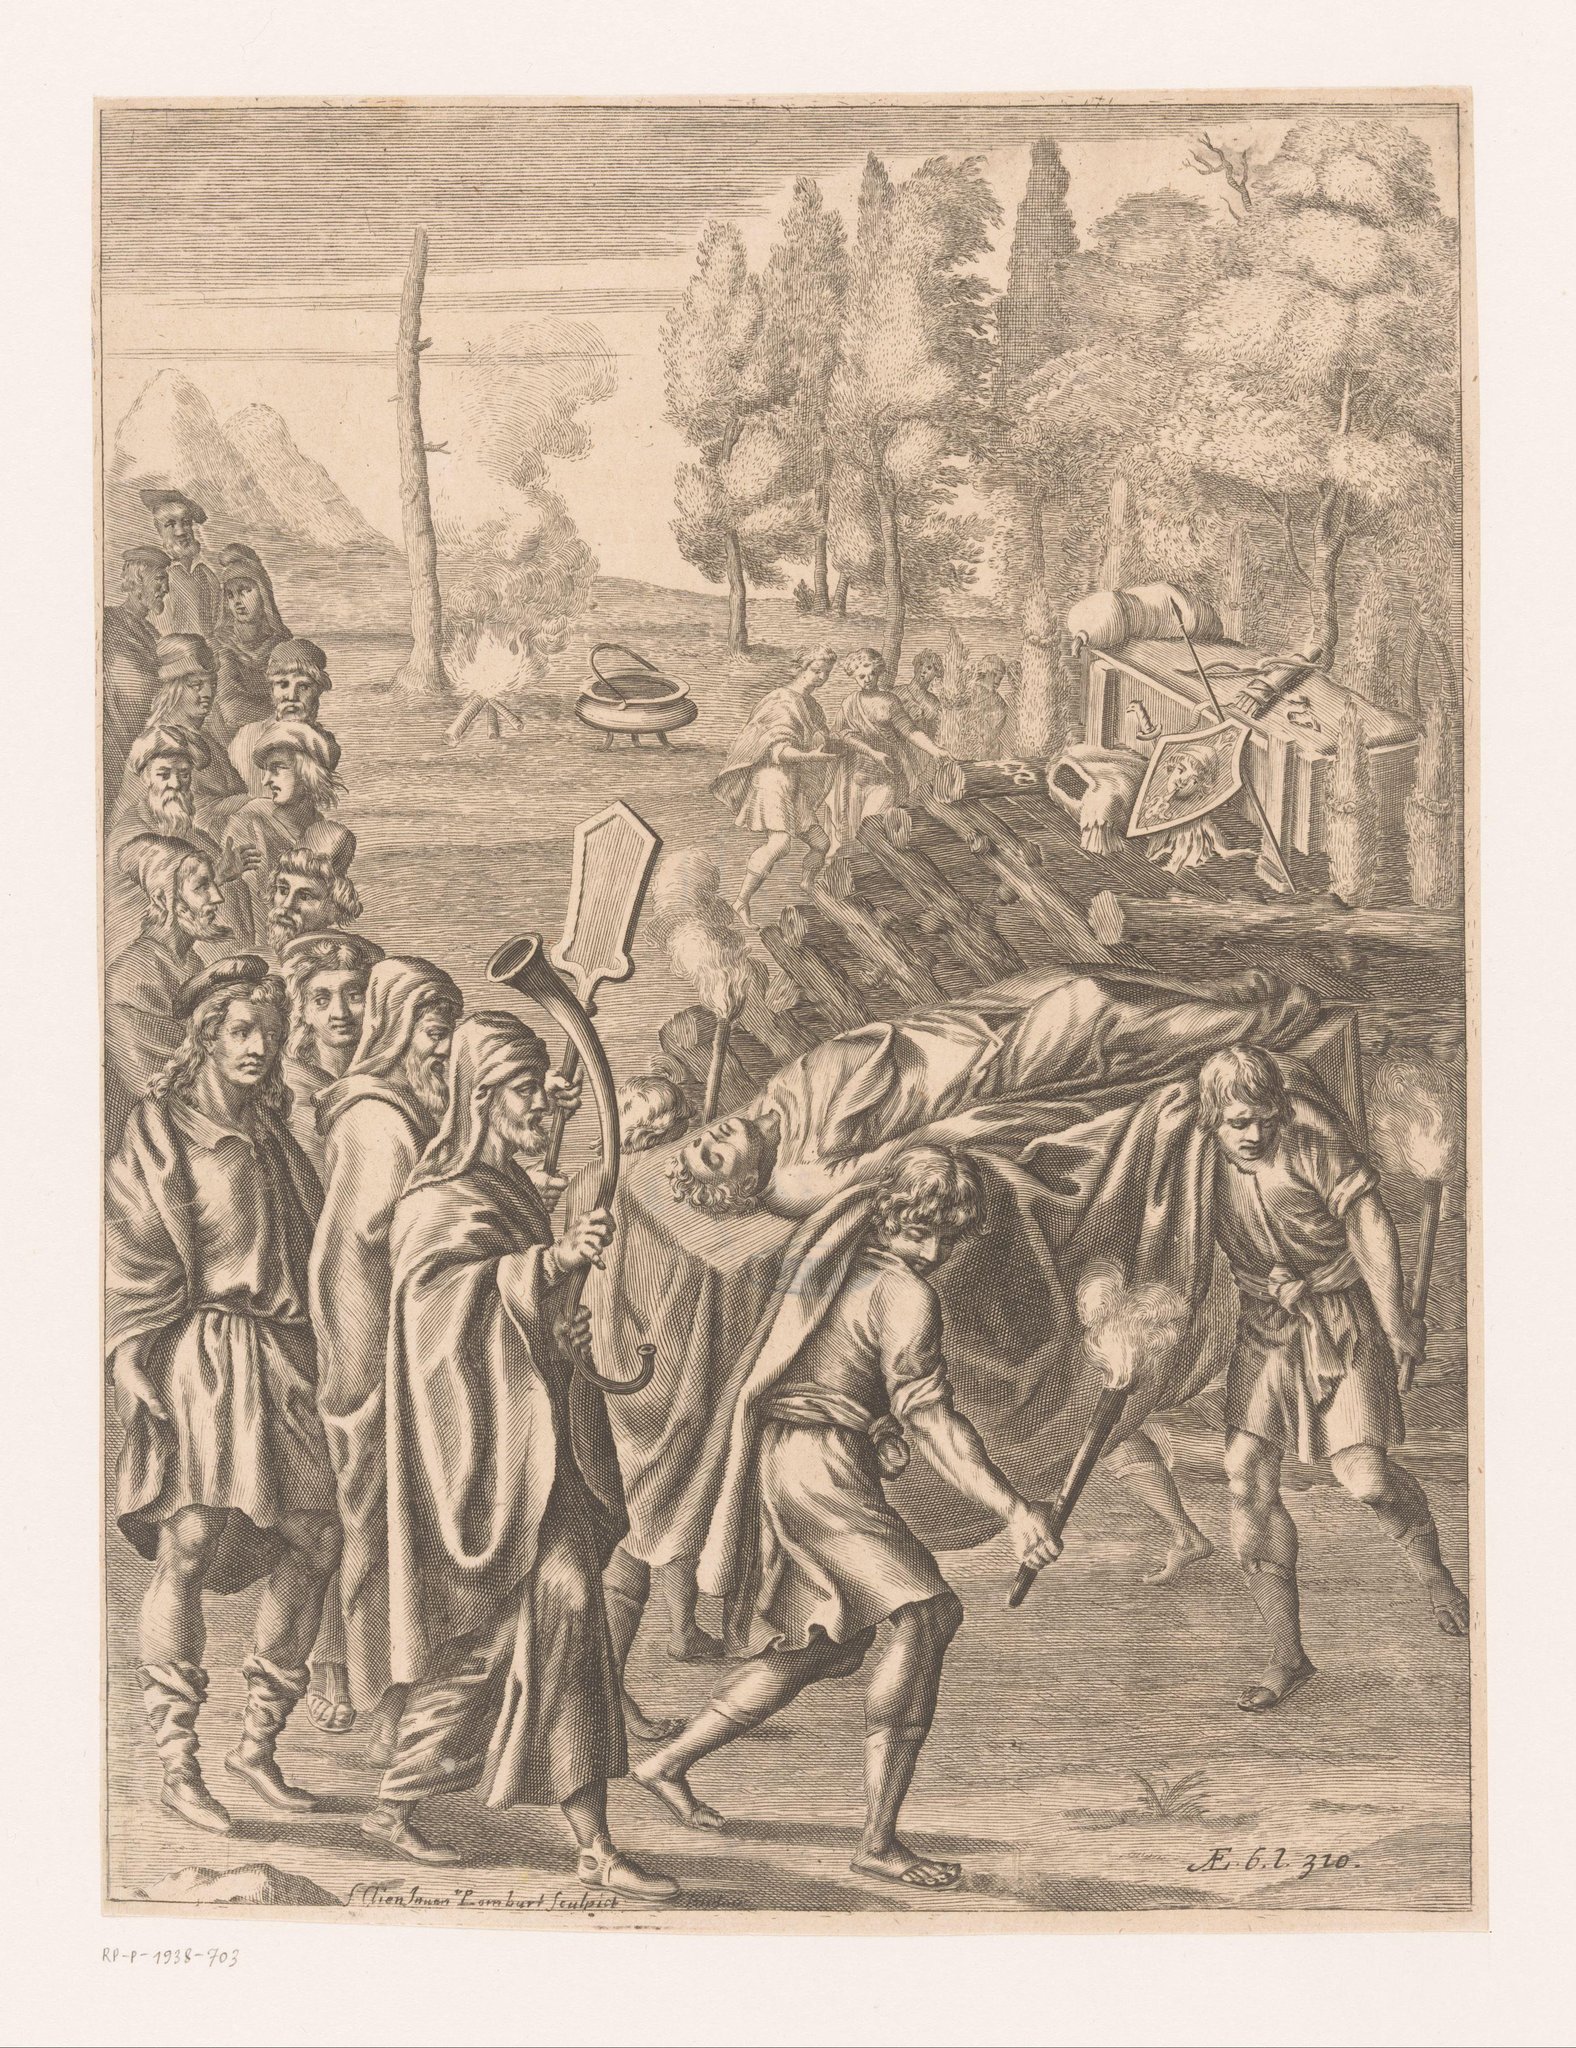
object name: book illustration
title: Man op draagbaar wordt naar de brandstapel geleid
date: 1654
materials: paper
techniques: engraving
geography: london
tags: body-burning, cremation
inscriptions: collector's mark: Lugt 2228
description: Waarschijnlijk prent uit: Ogilby, John. The works of Publius Virgilius Maro. Londen: s.n; 1654.